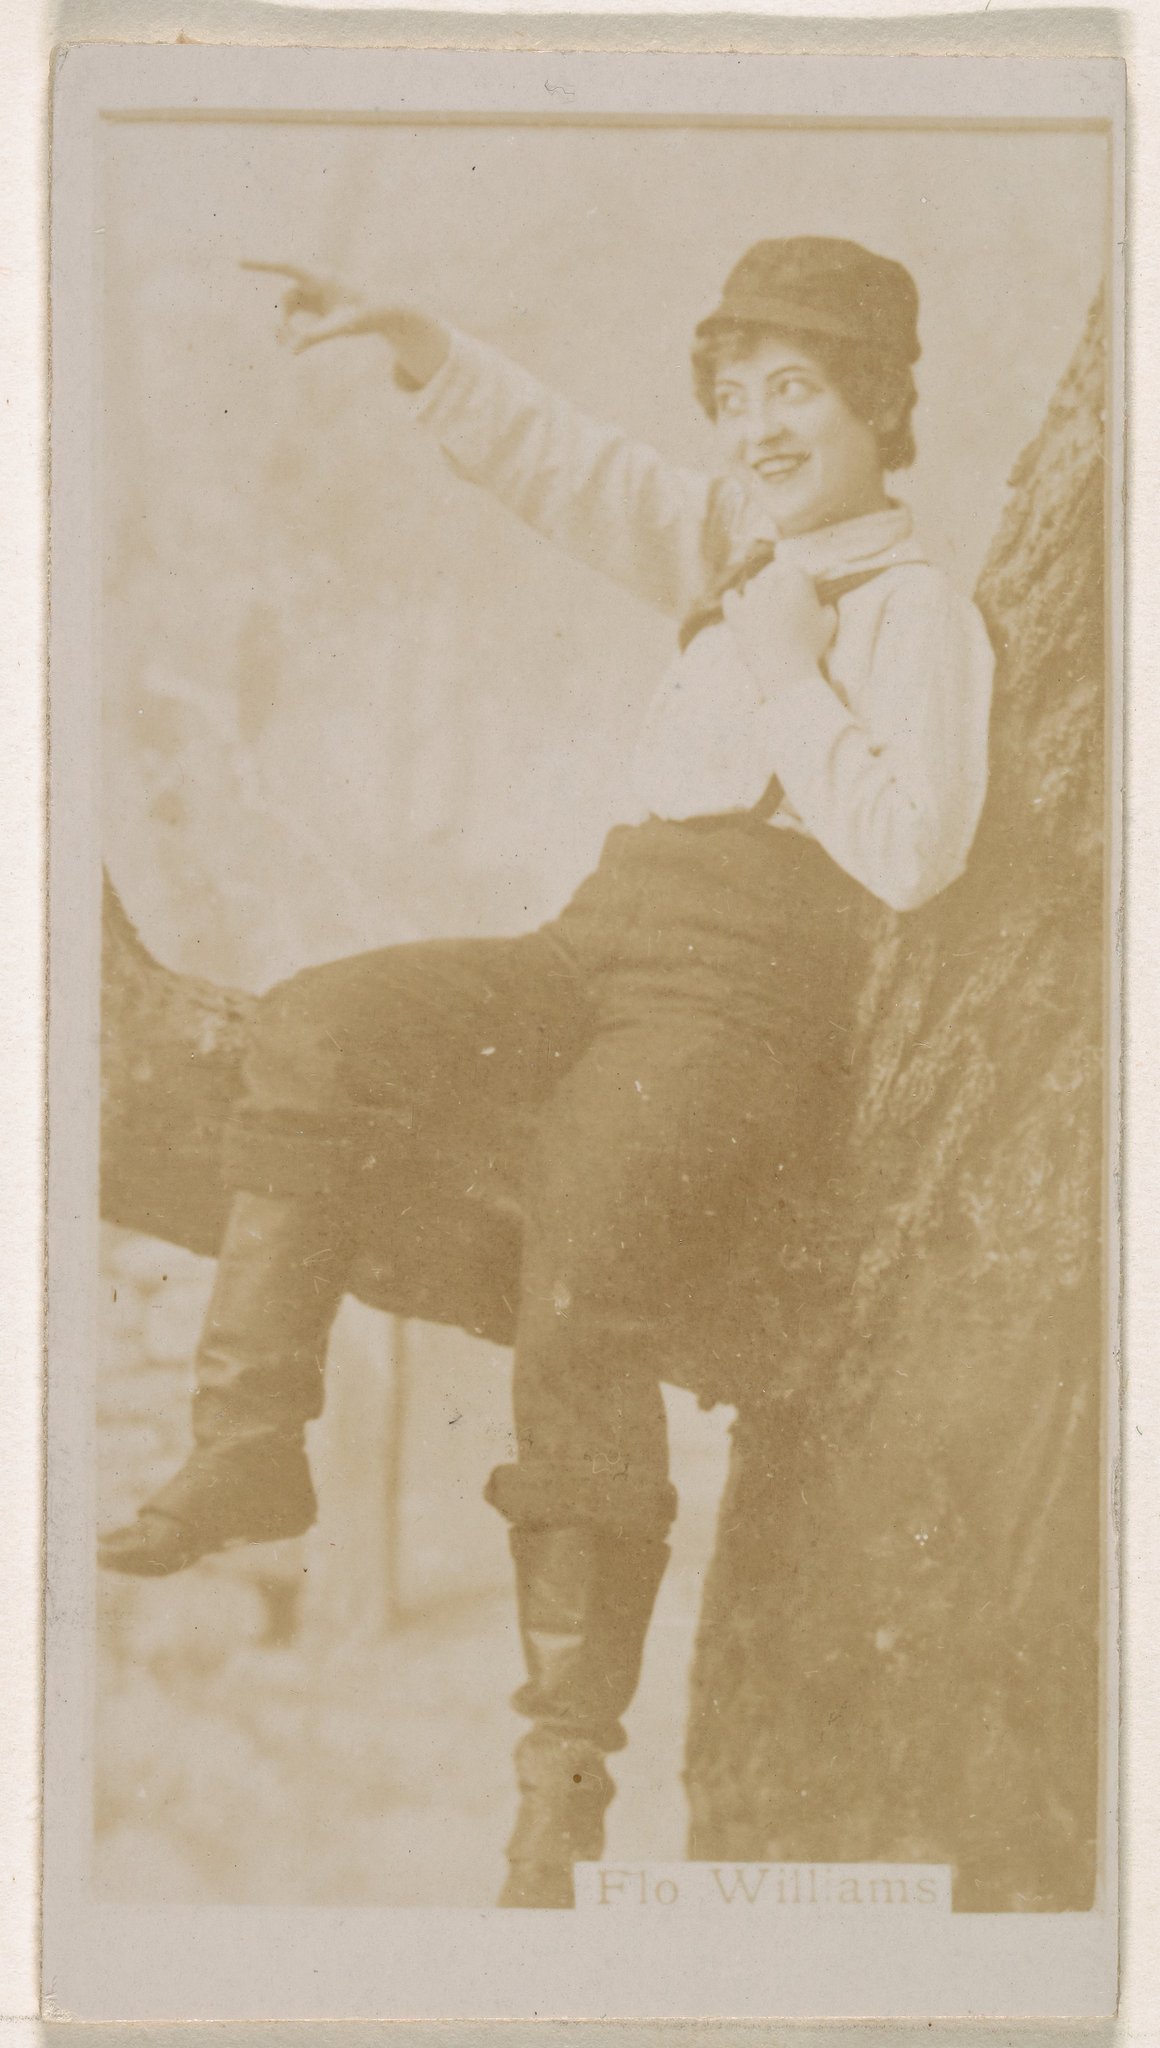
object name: photograph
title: Flo Williams, from the Actresses series (N245) issued by Kinney Brothers to promote Sweet Caporal Cigarettes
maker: kinney brothers tobacco company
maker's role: publisher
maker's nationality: american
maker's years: 1869-2011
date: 1890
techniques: albumen silver print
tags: portraits,women,actresses